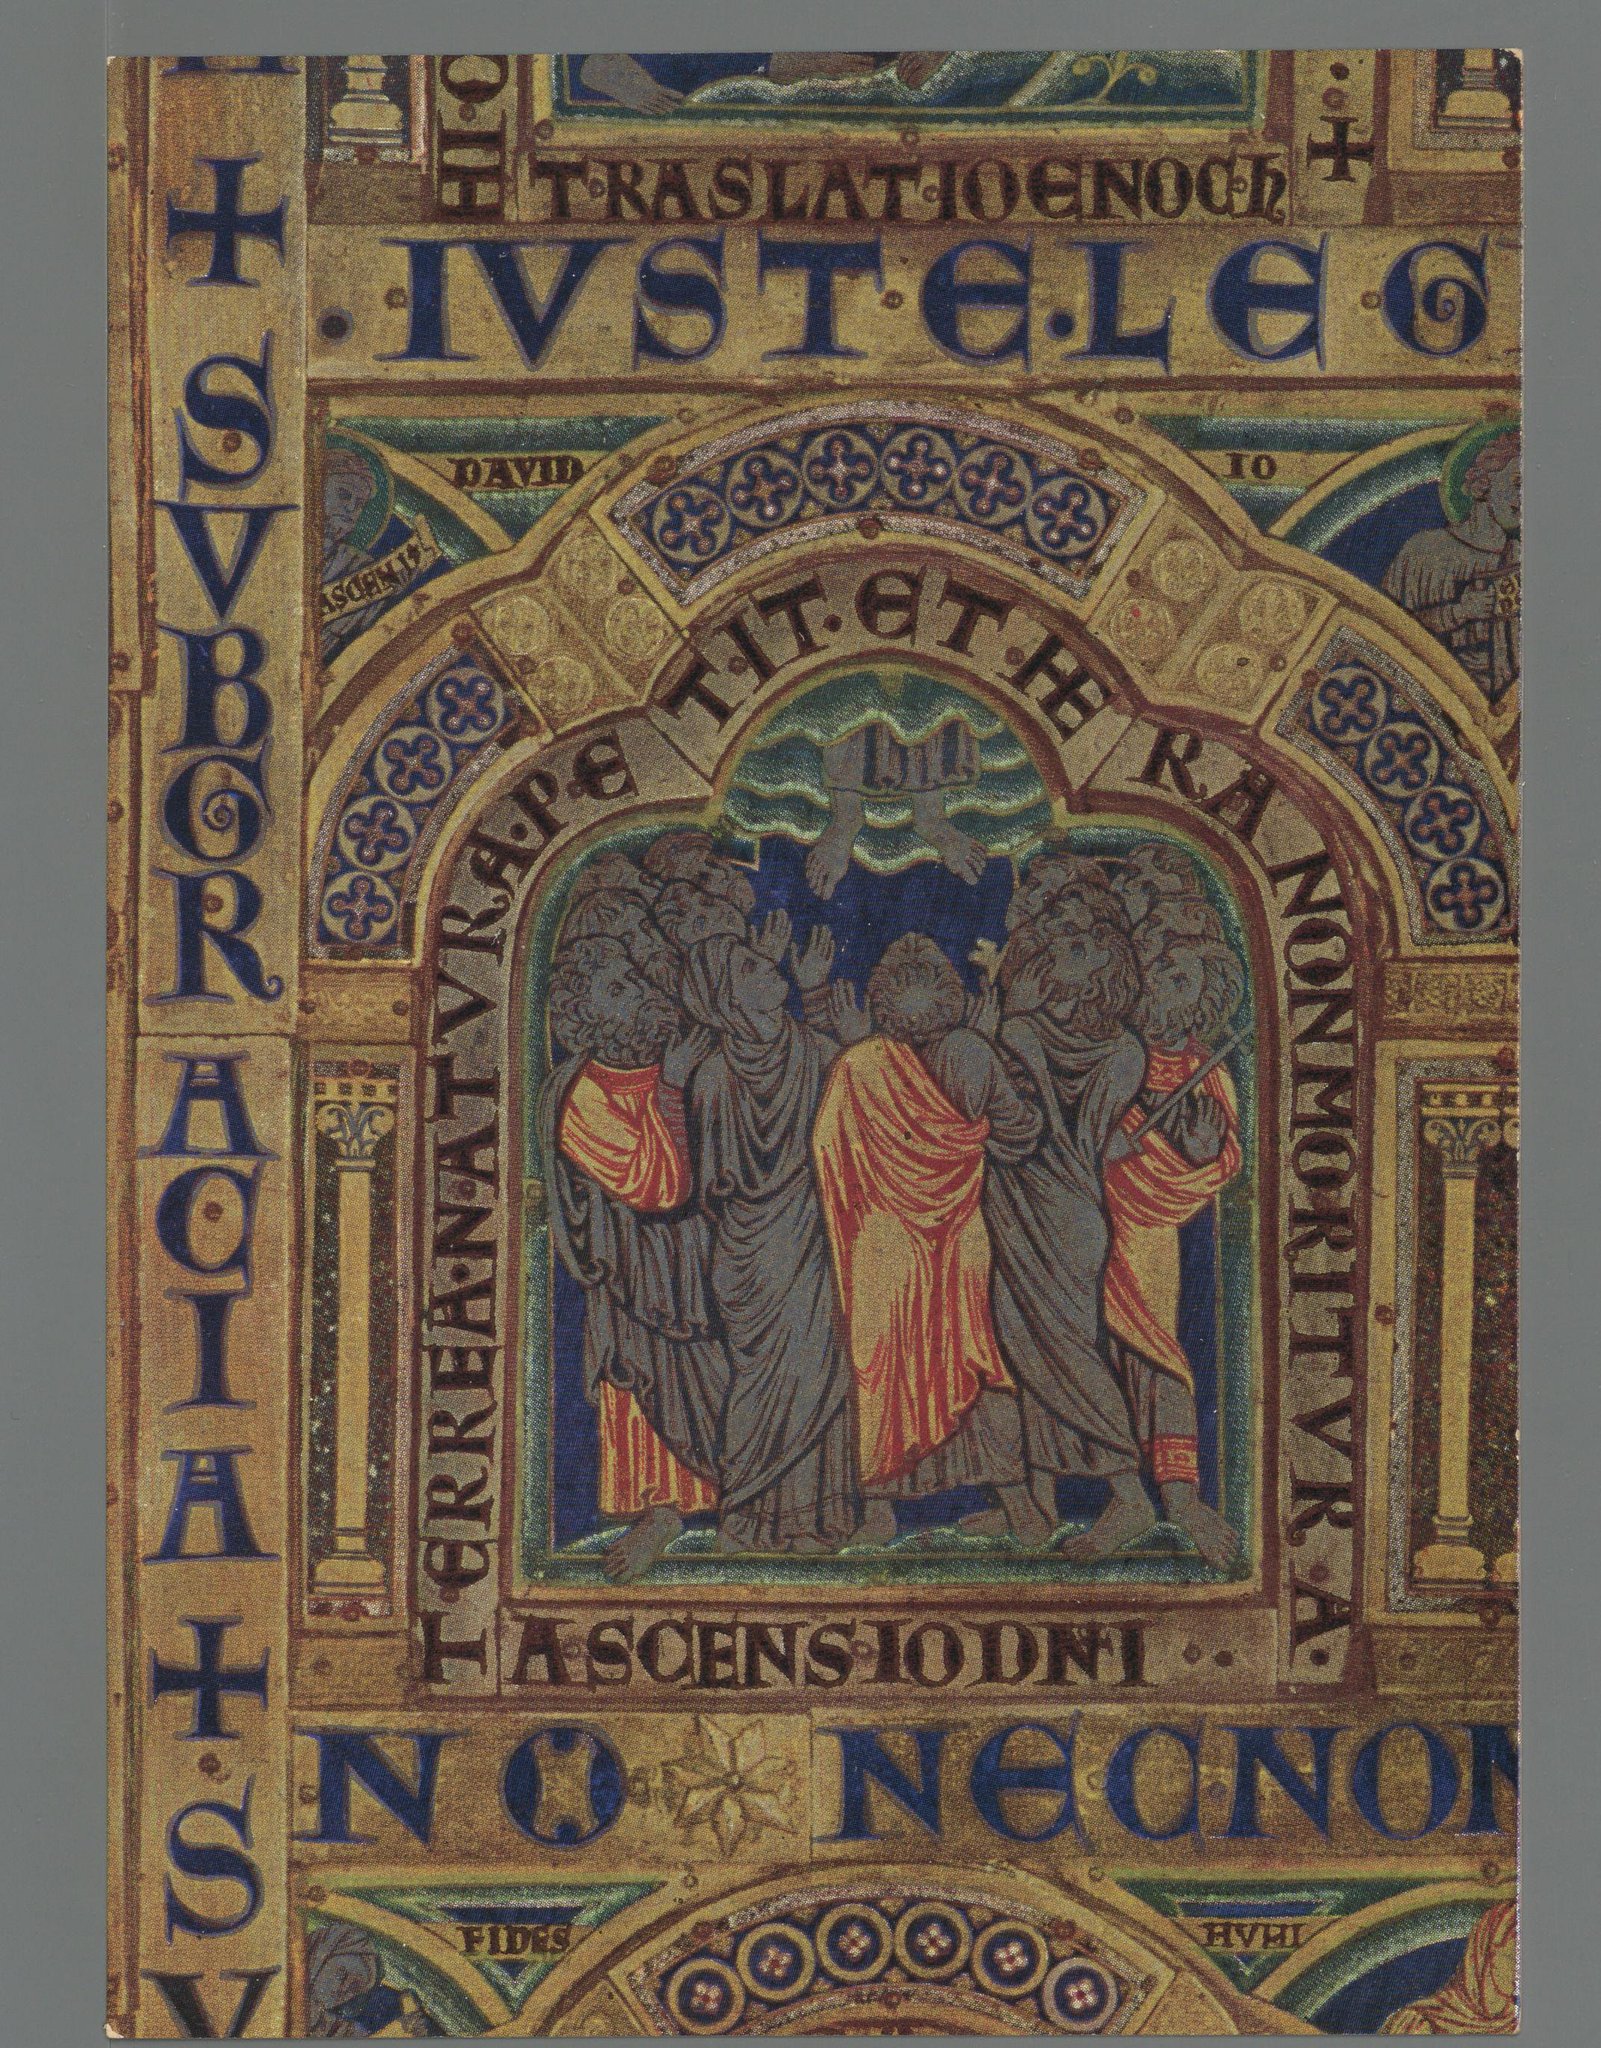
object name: photomechanical print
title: Der berühmte Verduner-Altar von Klosterneuburg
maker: Anonymous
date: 1927-1955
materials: cardboard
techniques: printing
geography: klosterneuburg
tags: interior of church, altar with altar-piece